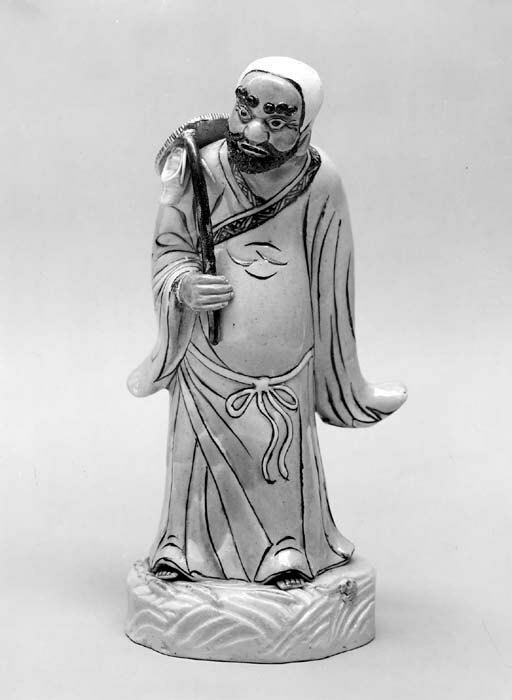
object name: figure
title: Figure of Bodhidharma Crossing Yangtze River on Reed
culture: chinese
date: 1662-1722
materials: biscuit, enamel, porcelain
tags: men,buddhism